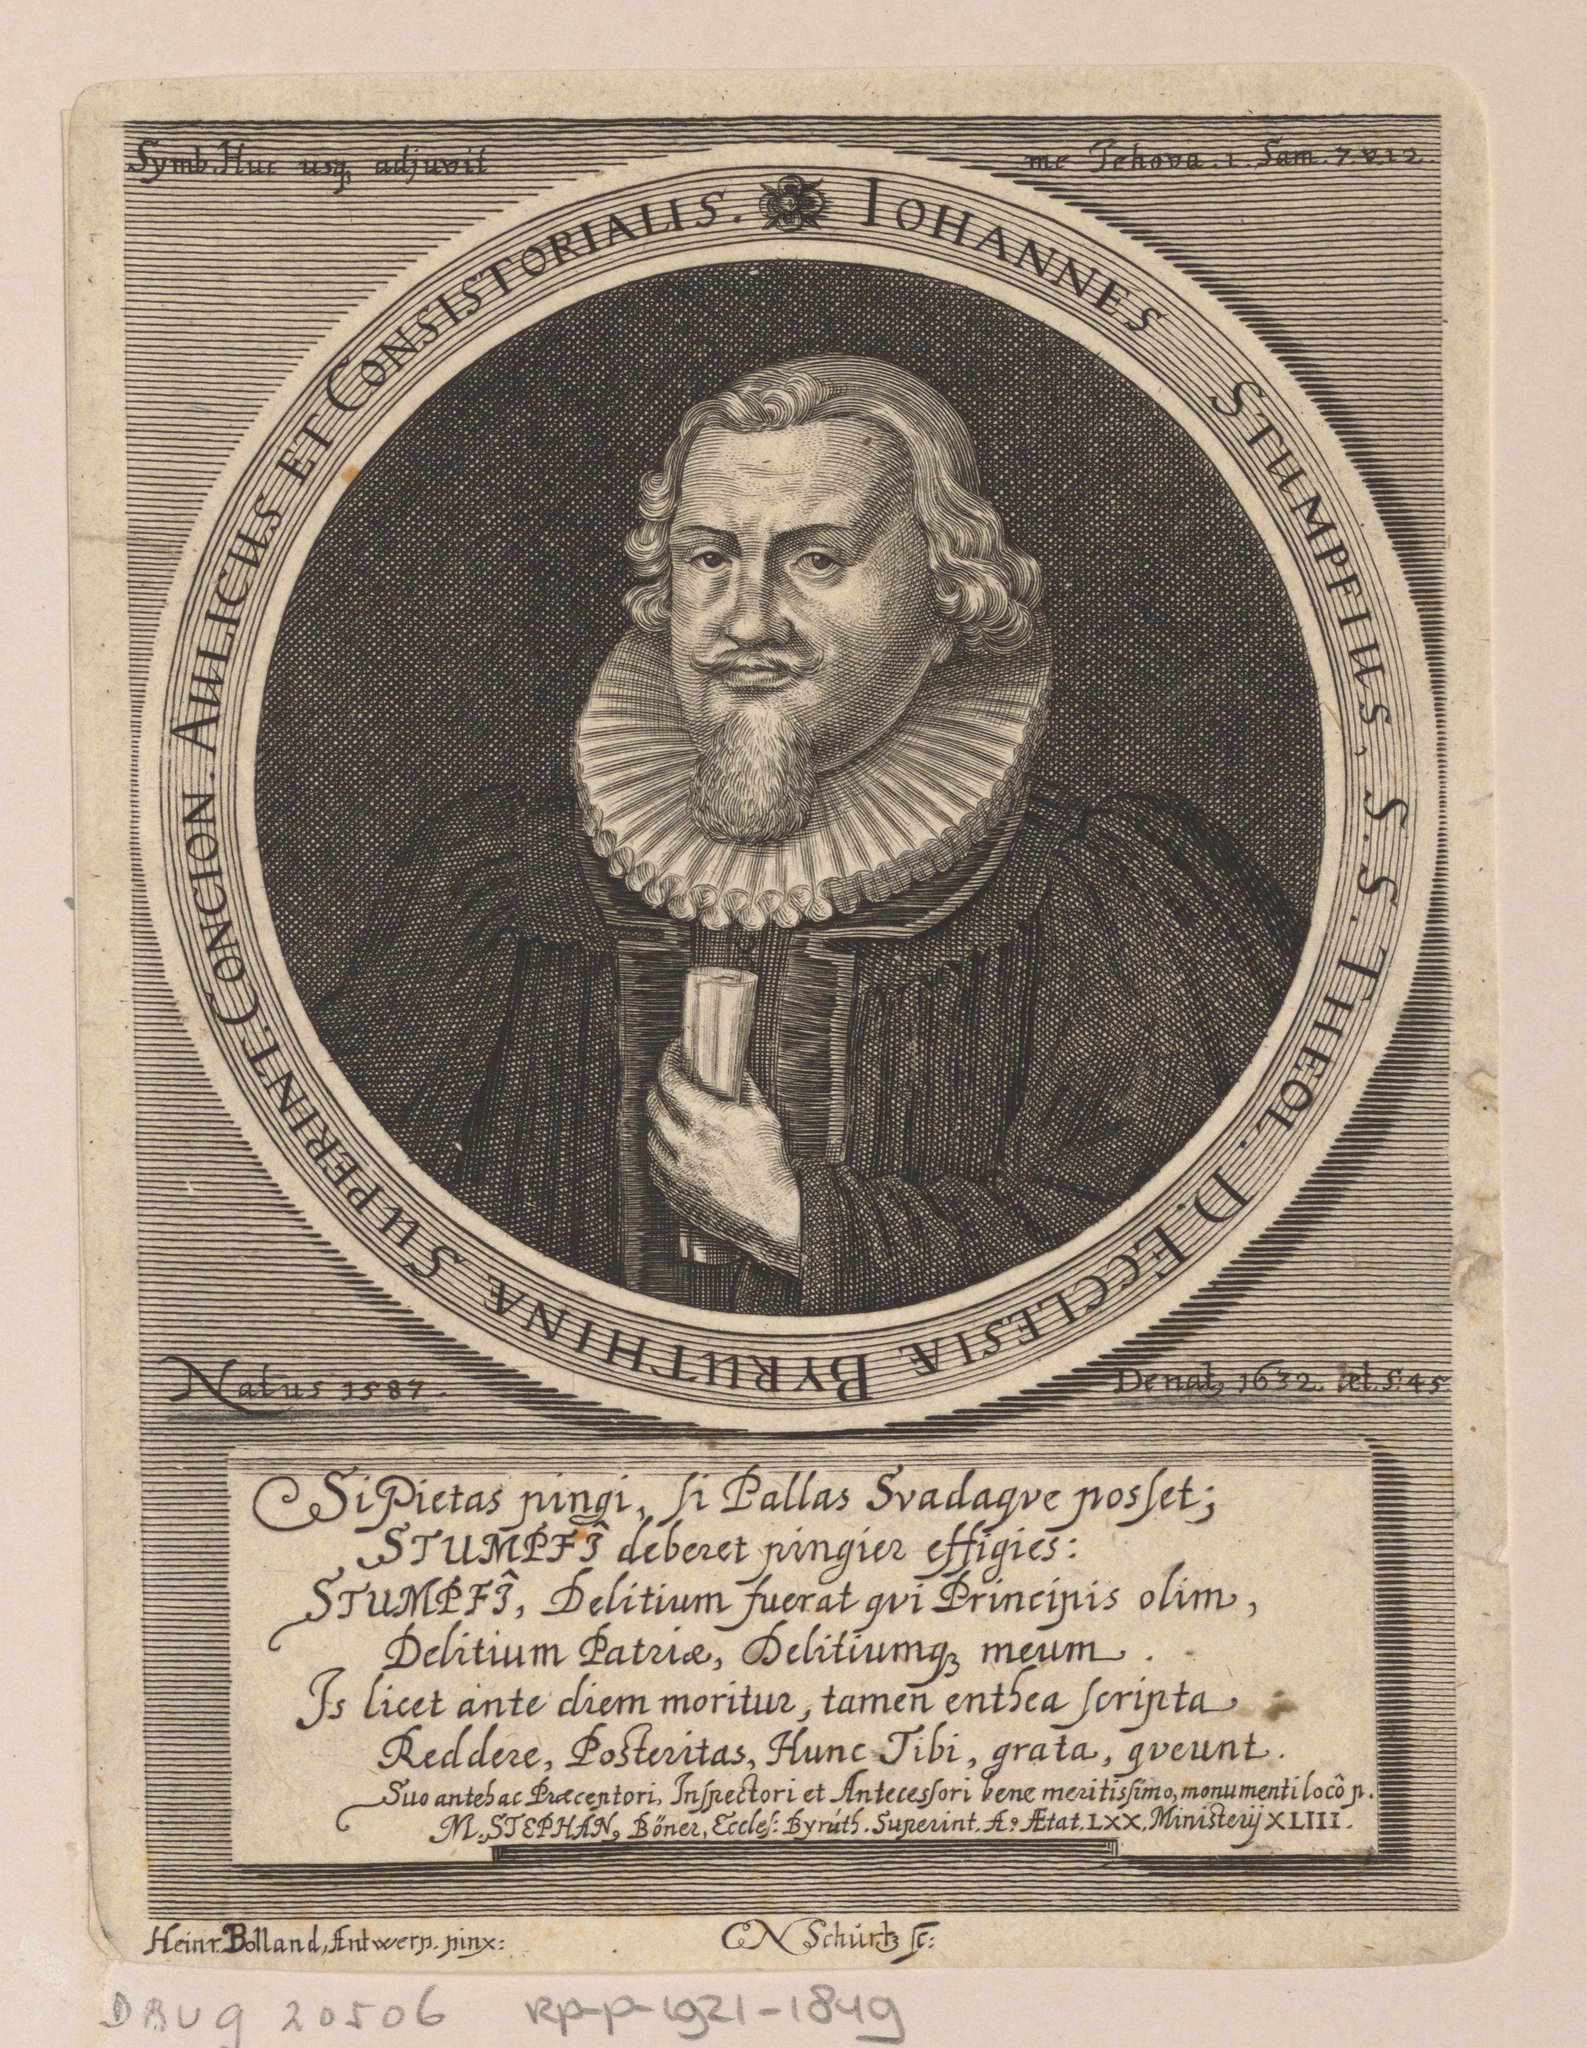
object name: print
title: Portret van Johannes Stumpf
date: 1651-1669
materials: paper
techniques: engraving, etching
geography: antwerp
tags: theologian, historical persons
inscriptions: collector's mark: Lugt 2233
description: Met zesregelig onderschrift in het Latijn.